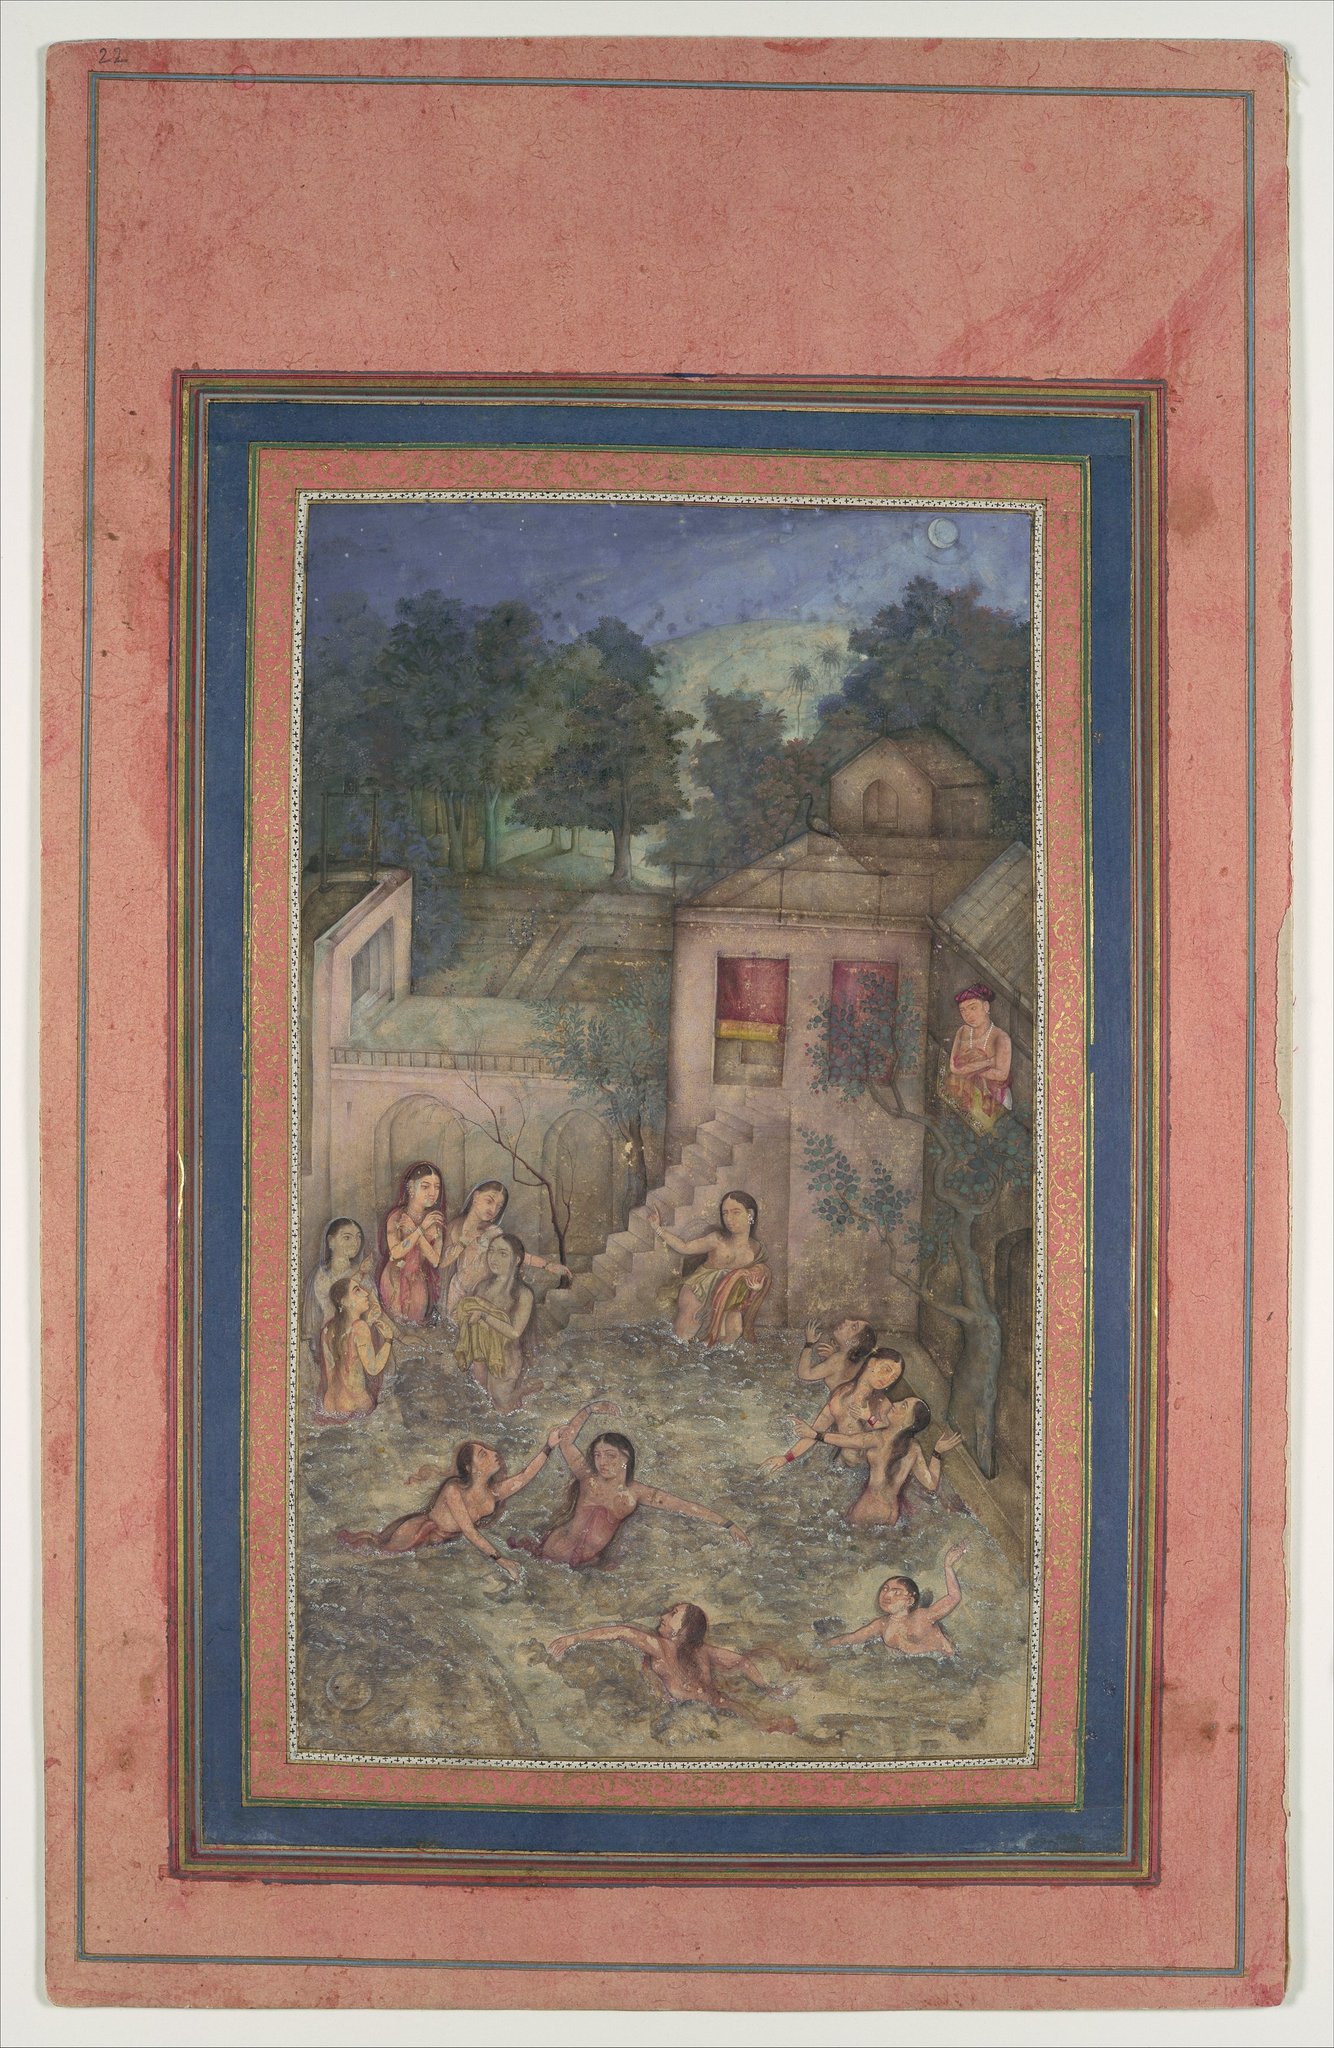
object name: illustrated album leaf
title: "Women Bathing by Moonlight", Folio from the Davis Album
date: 1701-1800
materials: gold, ink, paper, watercolor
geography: india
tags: men,women,bathing